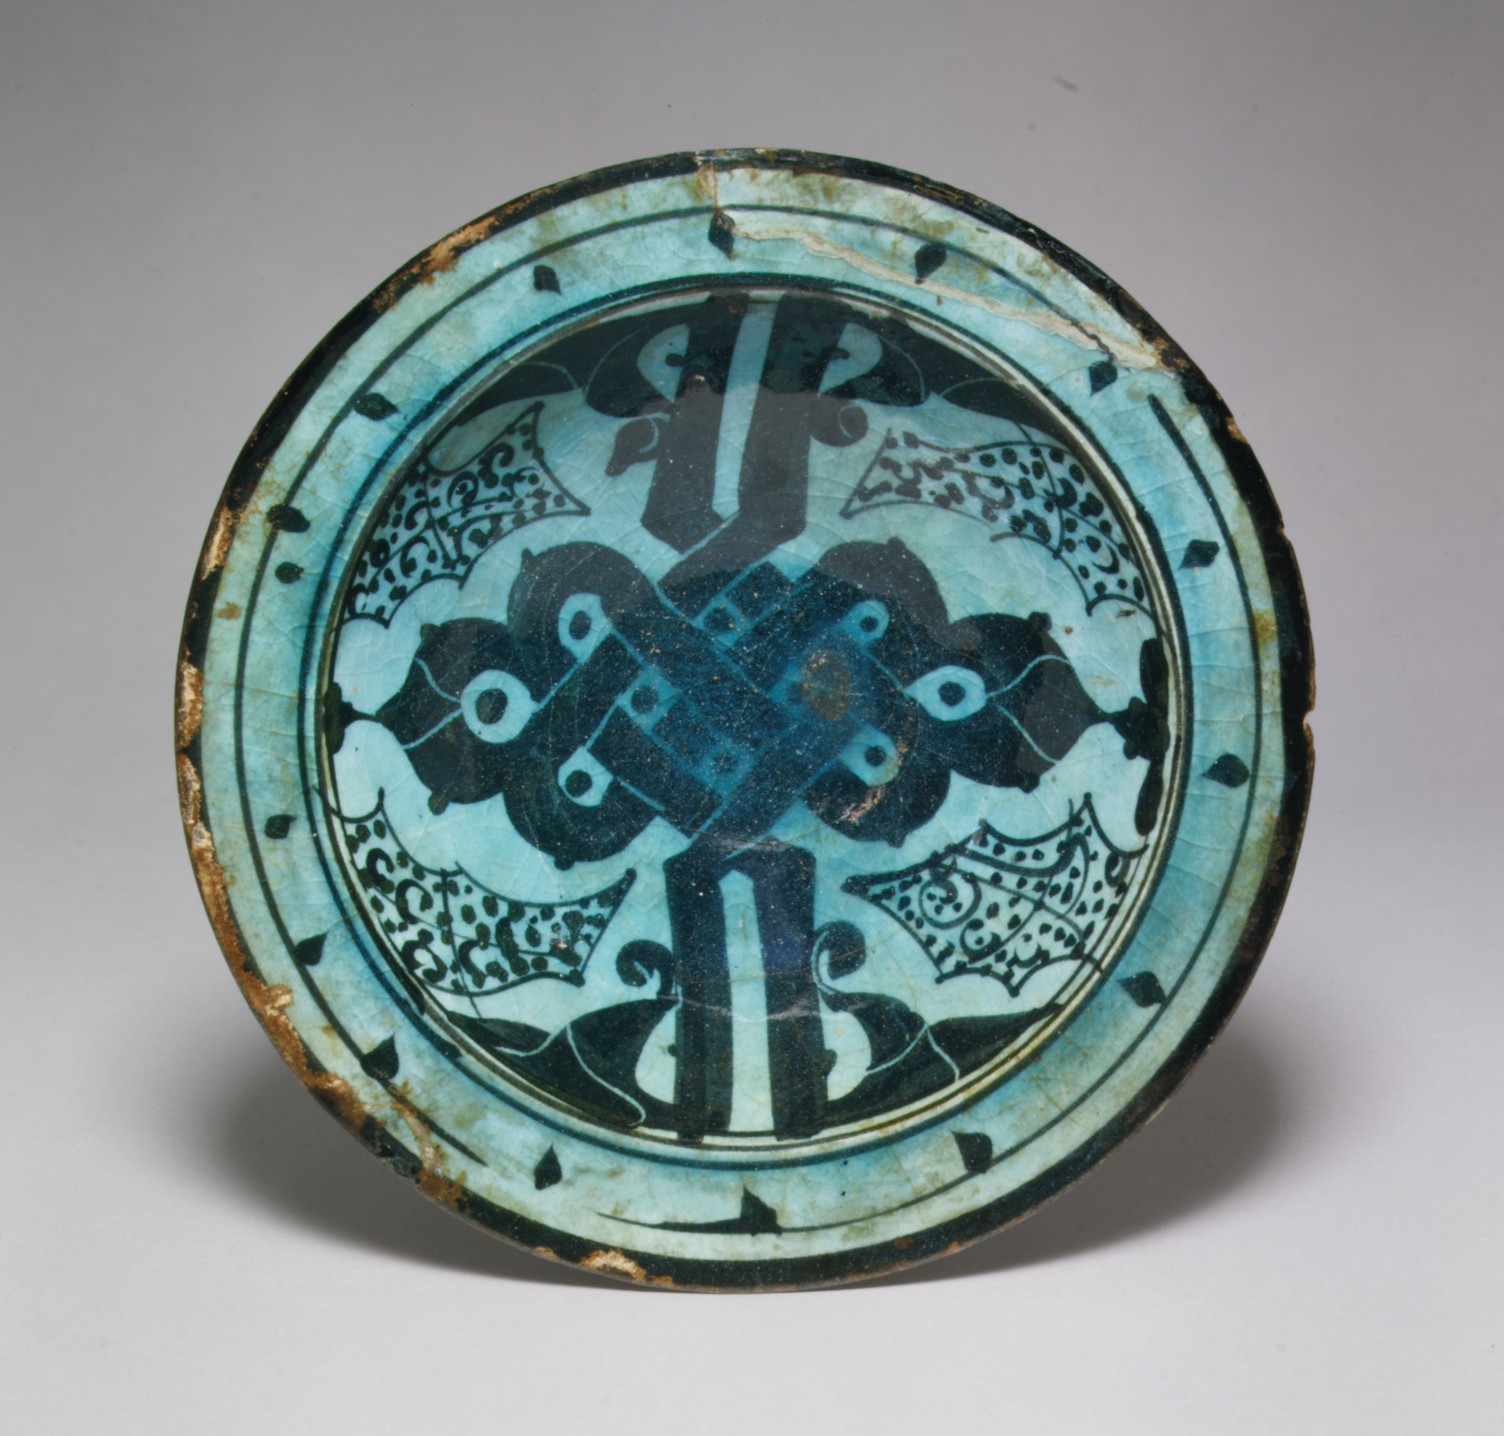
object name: bowl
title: Bowl with Alif-lam Motif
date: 1101-1200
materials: glaze, stonepaste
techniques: painting, polychrome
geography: syria